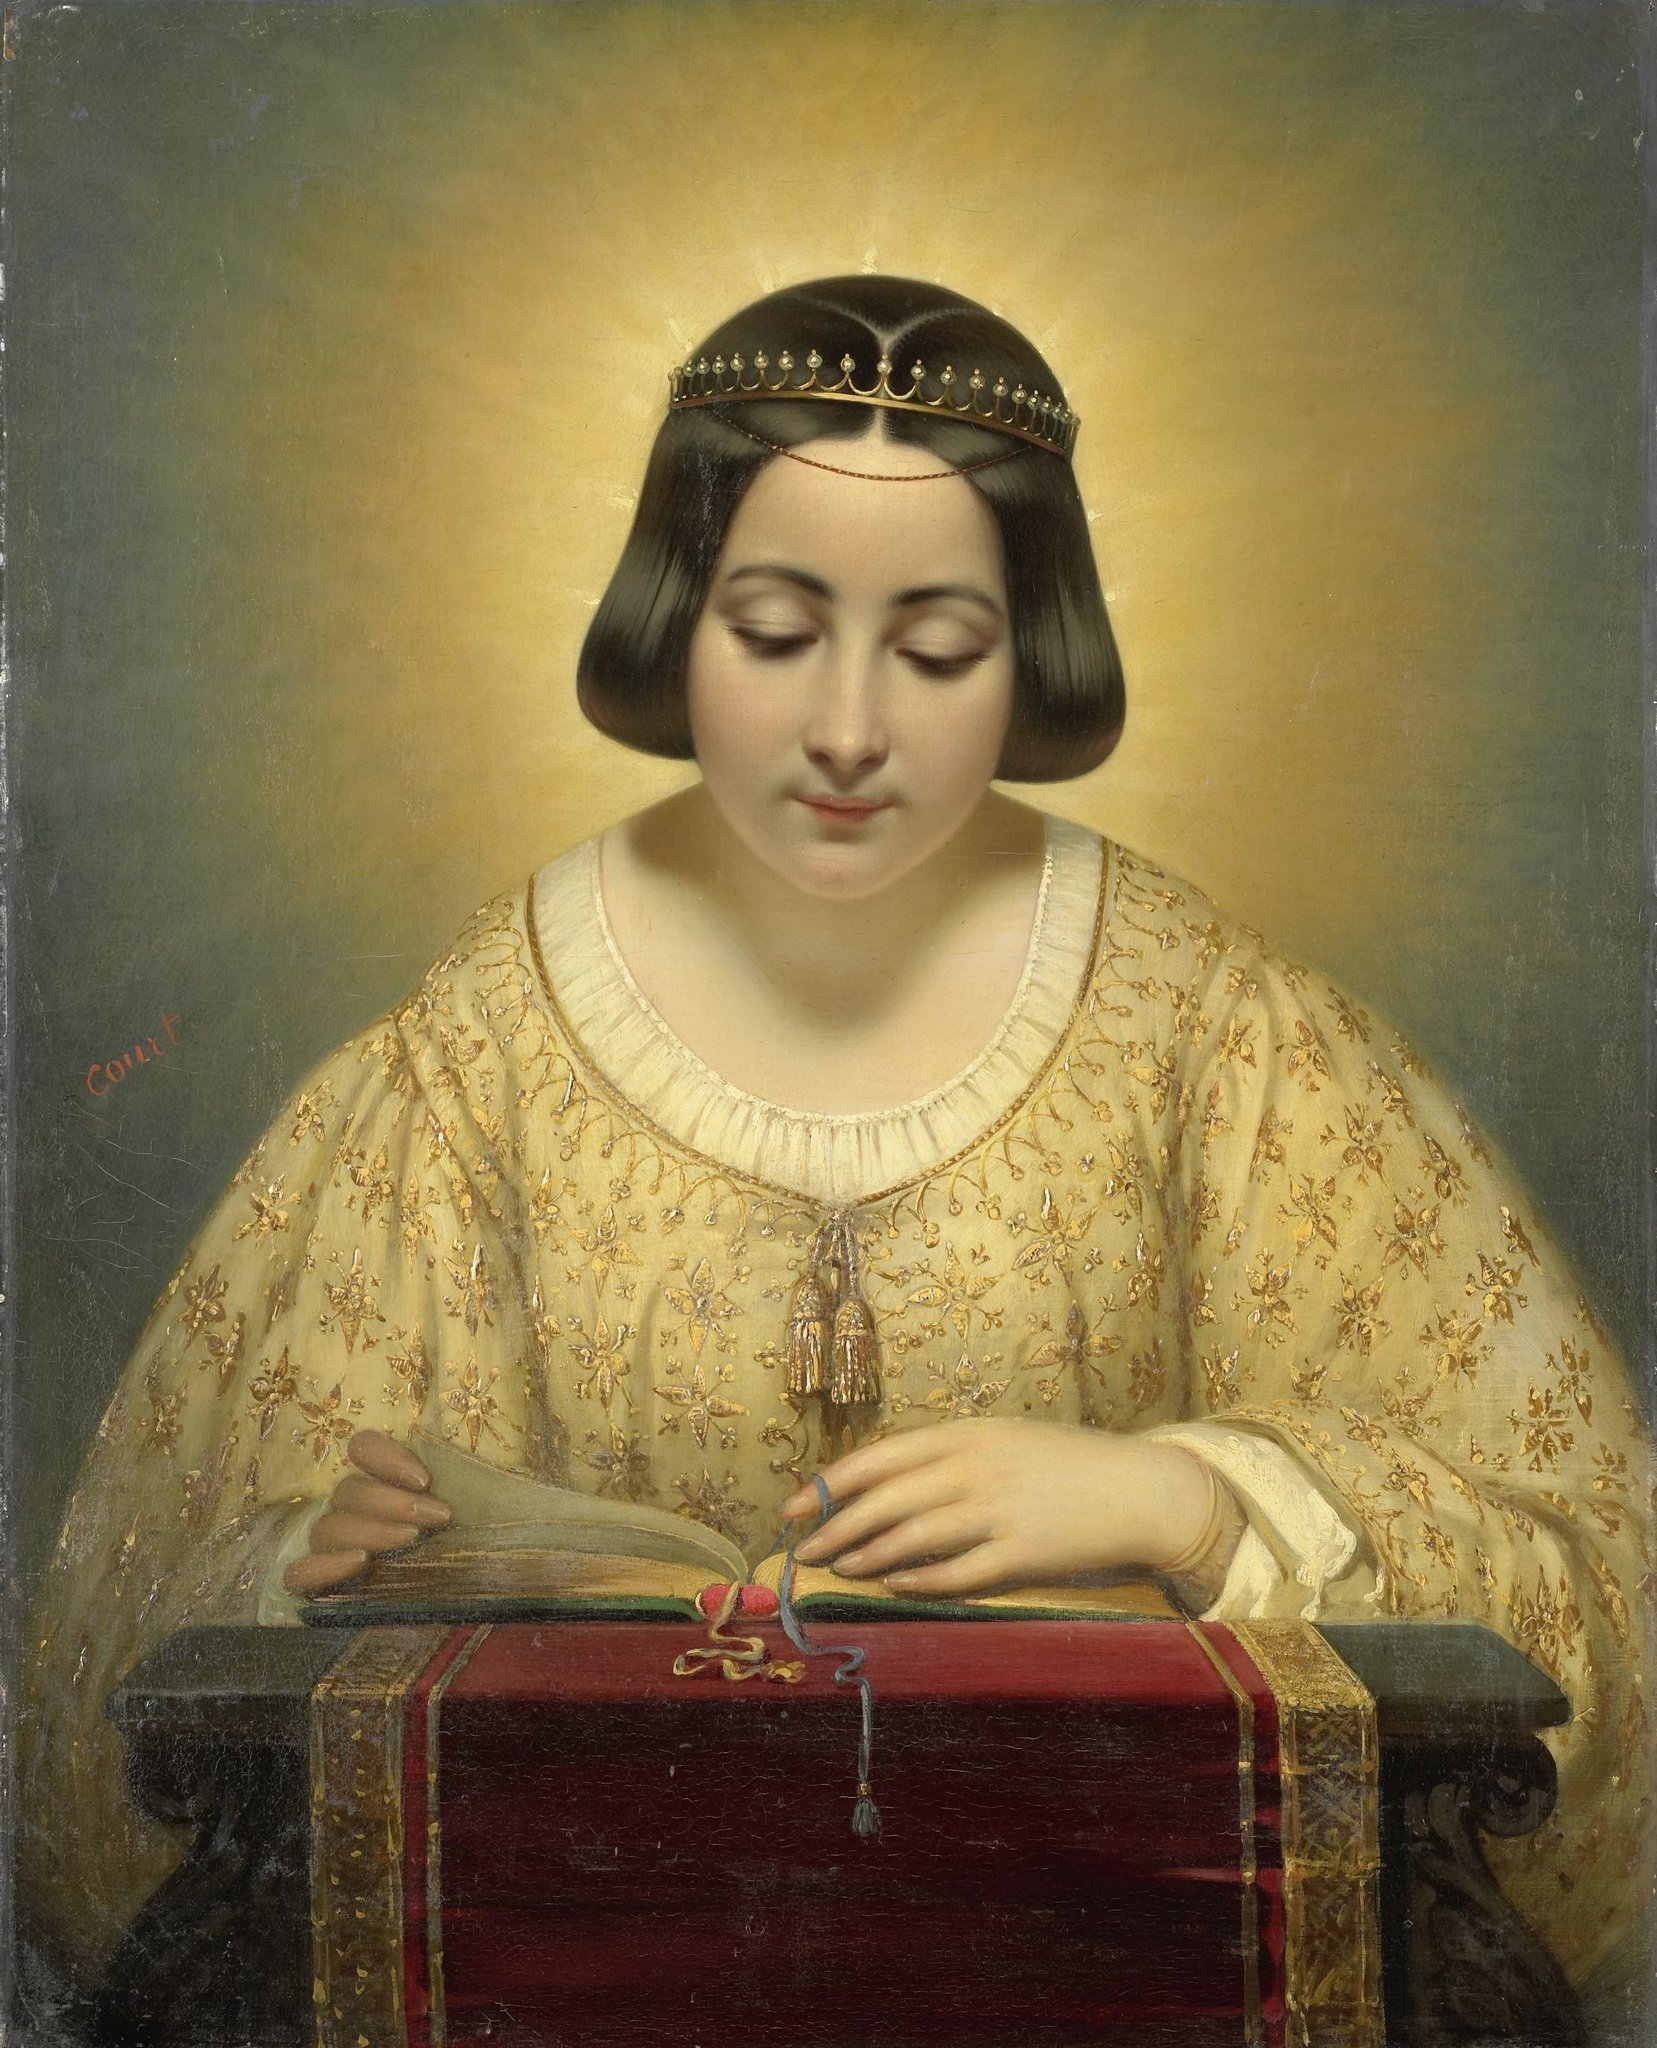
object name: painting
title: Saint Clare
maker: joseph désiré court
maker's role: painter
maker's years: 1797-1865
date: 1838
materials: canvas, oil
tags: the virgin martyr catherine of alexandria; possible attributes: book, crown, emperor maxentius, palm-branch, ring, sword, wheel, reading, historical persons - bb - woman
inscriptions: signature: ‘court.’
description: Saint Clare is reading the Bible, bathed in light. Also known as ‘the luminous one,’ Saint Clare was a 13th-century Italian nun who devoted herself to spirituality and renounced all earthly possessions. She gained a vast following and was canonized just four days after her death. The painter Court chose not to depict her in a habit, instead inventing a medievalinspired version of her clothing and hairstyle.